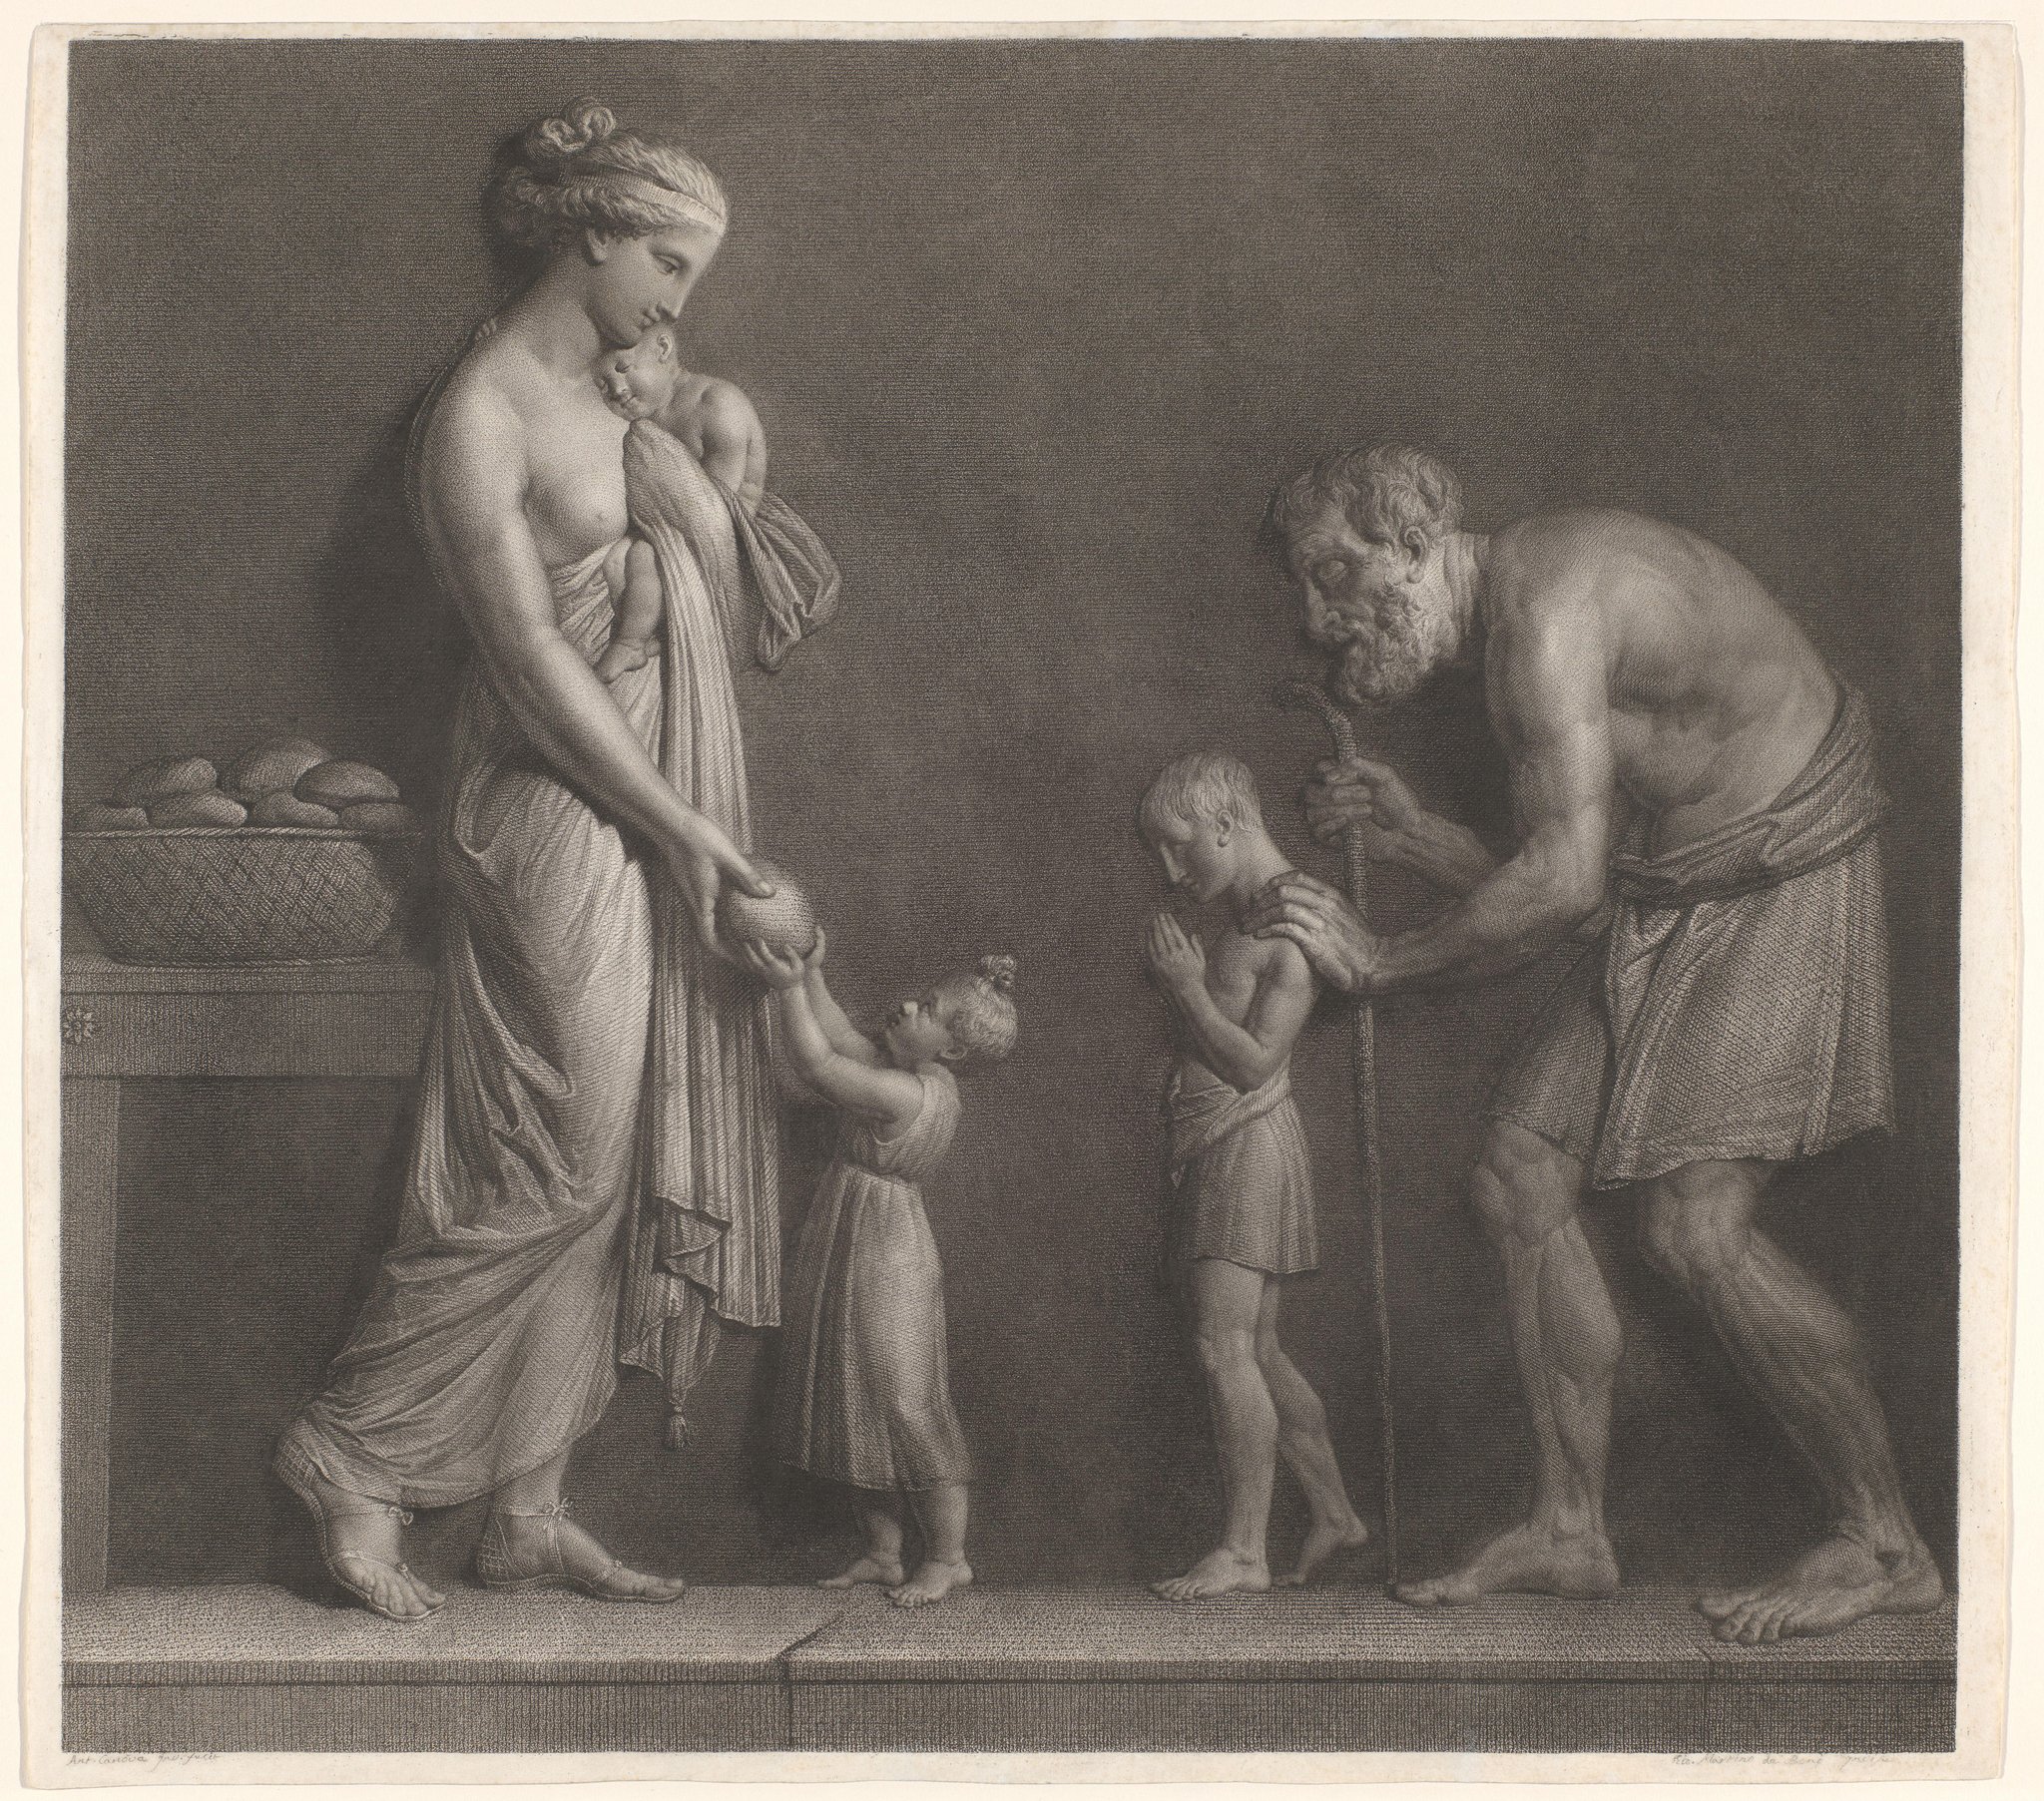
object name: print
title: Dar da mangiare agli affamati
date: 1803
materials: paper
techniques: engraving, etching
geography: italy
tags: feeding the hungry, 'esuriens cibatur' ~ one of the (seven) acts of mercy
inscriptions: collector's mark: Lugt 2228, collector's mark: Lugt 2760, inscription: ‘Ant. Canova Inv. Fecit Gio. Martino de Boni Incise’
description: Naar een gipsrelief van Canova. Dit, en de pendant voorstellend Het onderwijzen van de onwetenden, werden nooit uitgevoerd in marmer.